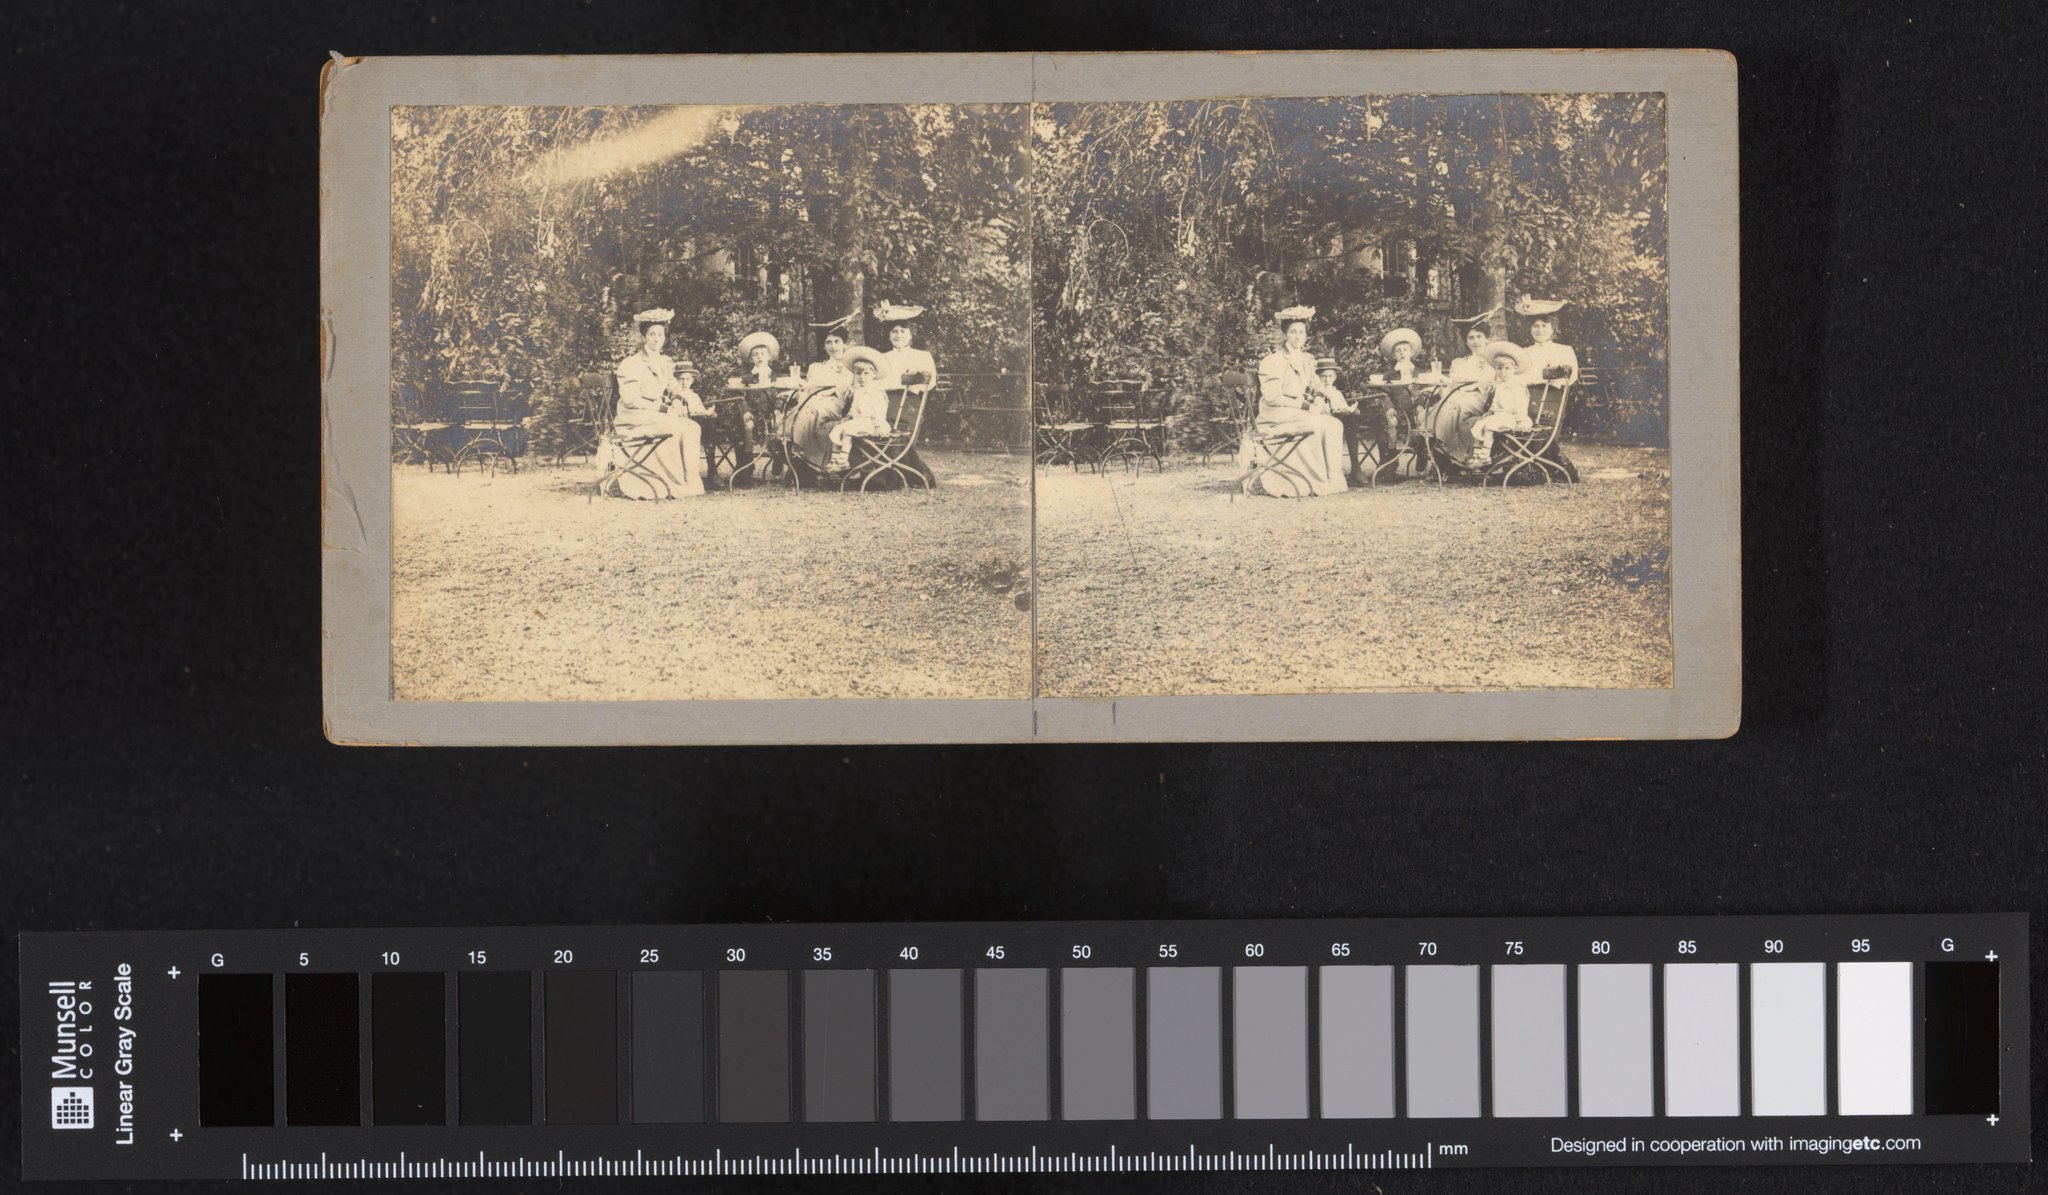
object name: stereograph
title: Vrouwen en kinderen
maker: robert julius boers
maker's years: 1867-1932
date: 1900-1922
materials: cardboard, photographic support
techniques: gelatin silver print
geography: bangka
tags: robert julius boers, dutch east indies, the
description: Portret van Europese vrouwen en kinderen met hoeden op aan een tafel in de tuin, waarschijnlijk te Banka. Onderdeel van een groep stereofoto's van Robert Julius Boers, chef van het staatsbedrijf de Banka-tinwinning op Banka, uit de periode ca. 1900-1922.